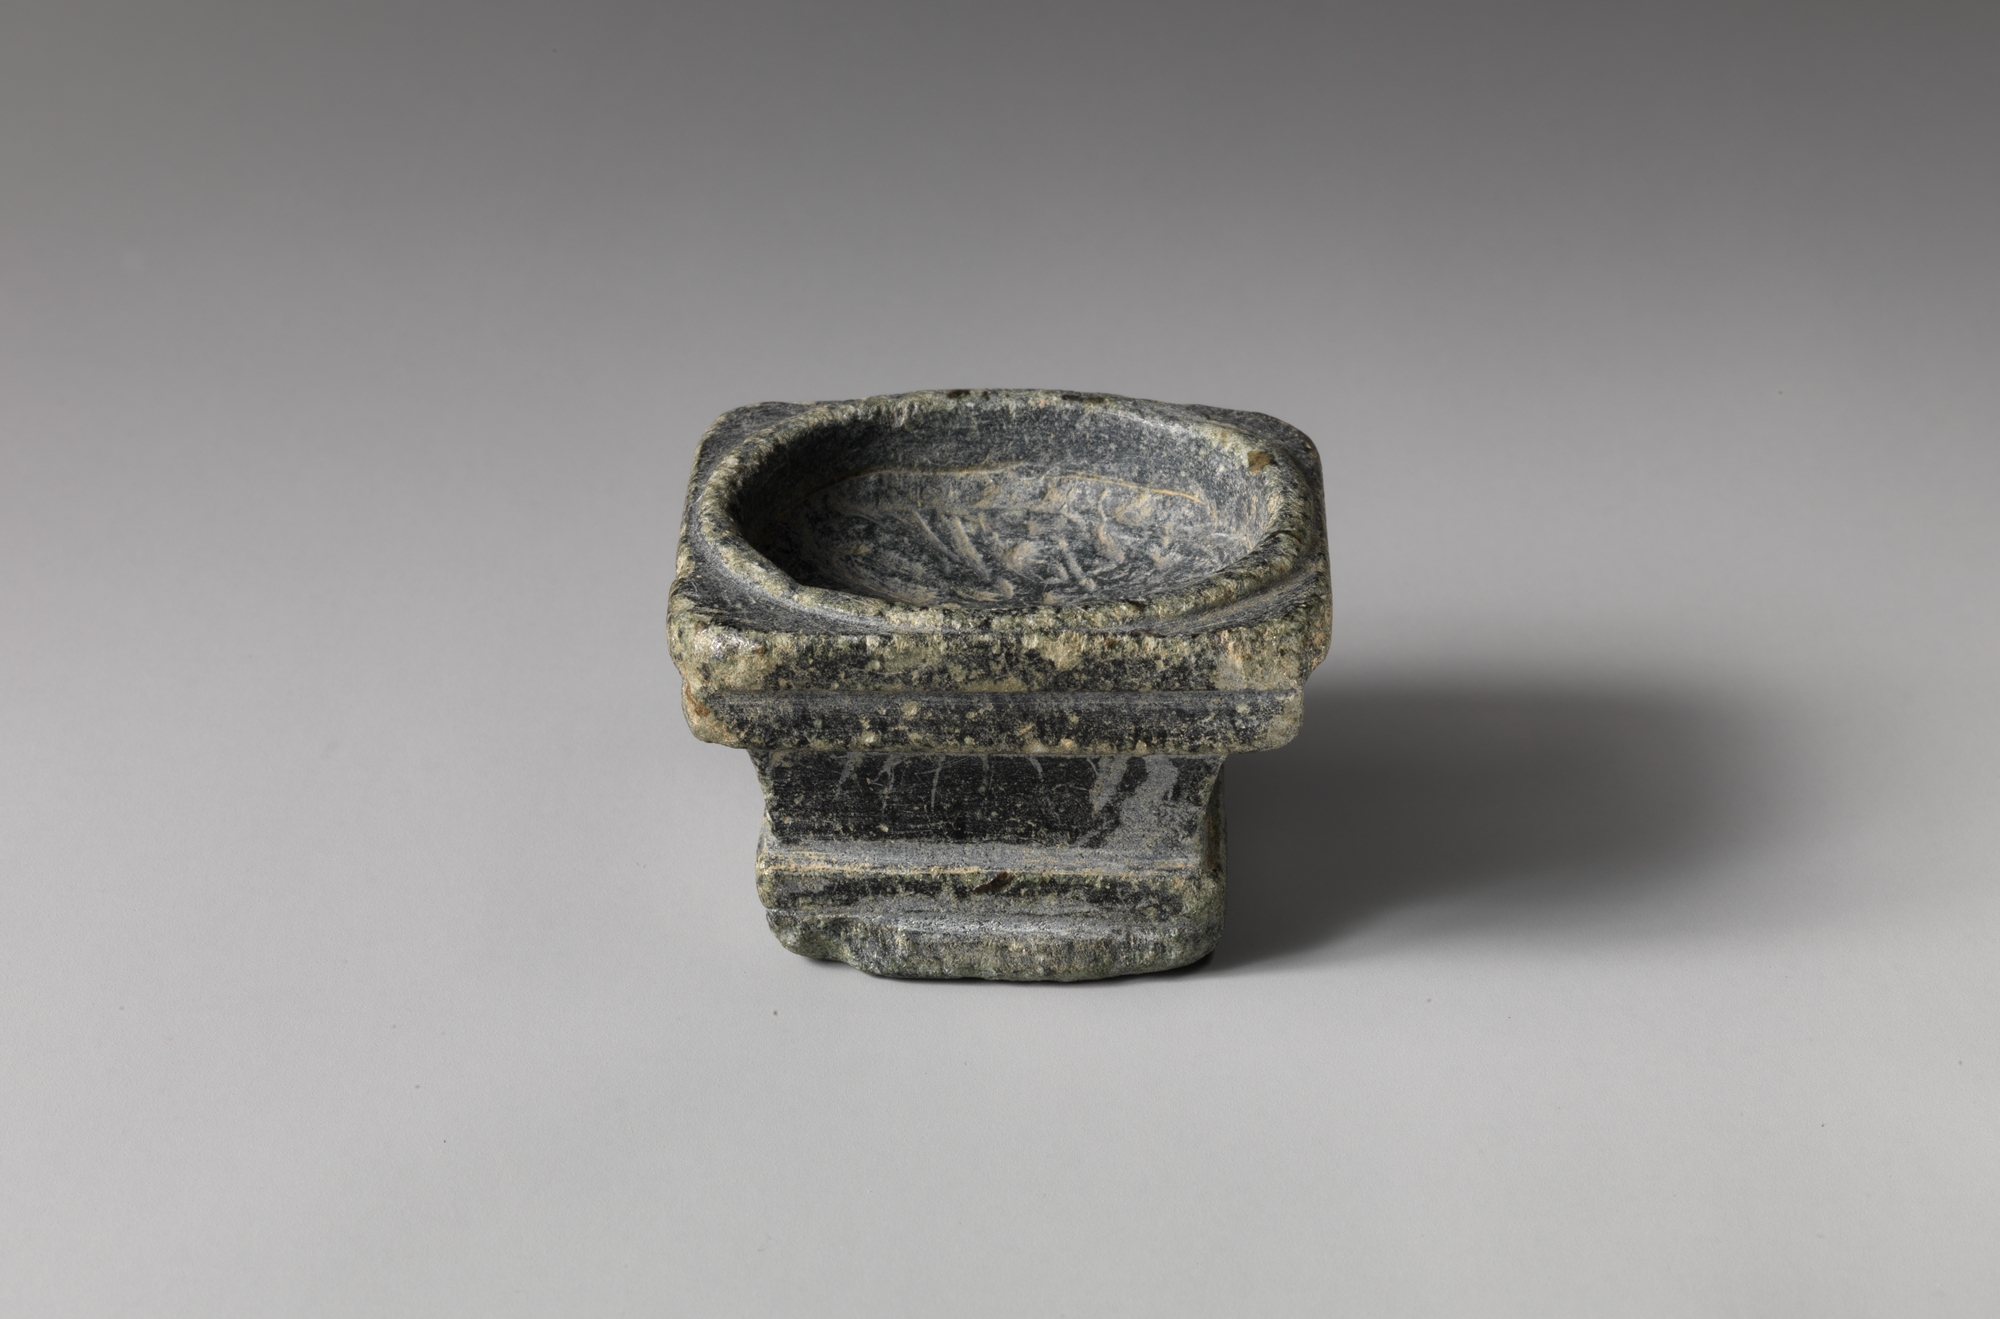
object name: offering table four stone receptacle together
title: Steatite miniature offering table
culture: minoan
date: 2000-1700 BCE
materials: stone